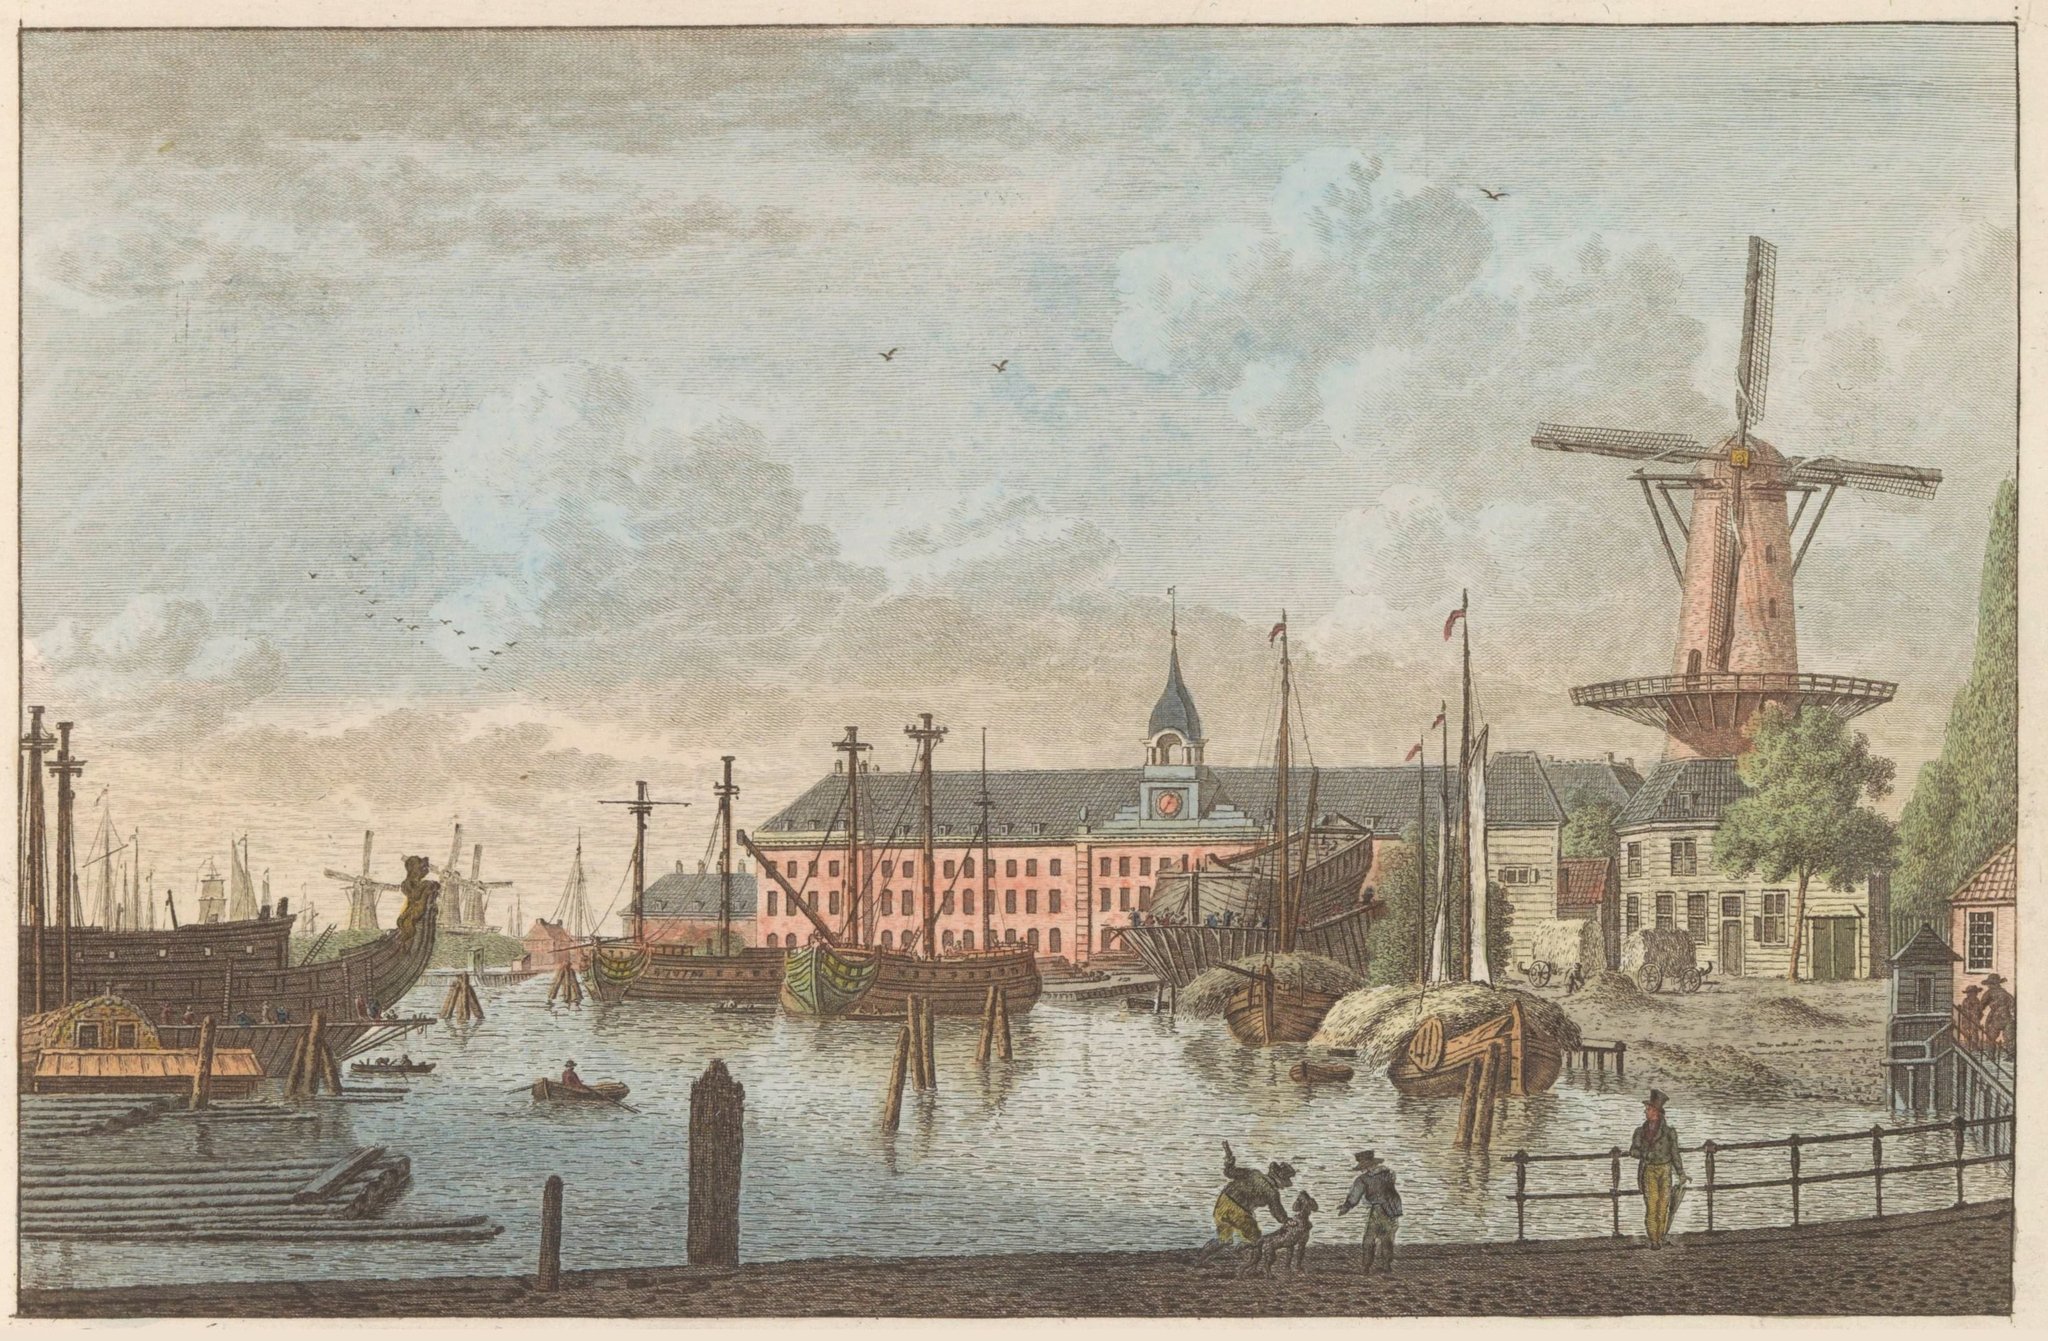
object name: print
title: Admiraliteits-Magazyn te Rotterdam / Les magasins de L'admirauté à Rotterdam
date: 1786-1792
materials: paper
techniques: engraving, etching, hand coloring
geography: netherlands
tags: slipway ~ shipbuilding, pier, quay, wharf, shipyard, shipdock, rotterdam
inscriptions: inscription: ‘chez E: Maaskamp à Amsterdam’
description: Huidige staat van prent uitgegeven als onderdeel van een plaatwerk uit ca. 1824-1825 met 74 (ongenummerde) platen van de belangrijkste topografische gezichten en verschillende zeden en gewoonten in het Verenigd Koninkrijk der Nederlanden, getiteld 'Tableau des principales vues des palais et édifices : représentations et des coutumes et usages, dans les provinces septentrionales du Royaume des Pays-Bas'. Eerdere staat gebruikt in: Vaderlandsche gezichten, of afbeeldingen van den tegenwoordigen staat der Vereenigde Nederlanden (…). Amsterdam: Hendrik Gartman, Willem Vermandel en Jan Willem Smit, 1786-1792. Uitgegeven in afleveringen met ieder een eigen bifolium en inhoudsopgave. Alle prenten in deze publicatie zijn gegraveerd door Carel Frederik Bendorp (I) en, in de meeste gevallen, gebaseerd op tekeningen van Jan Bulthuis.